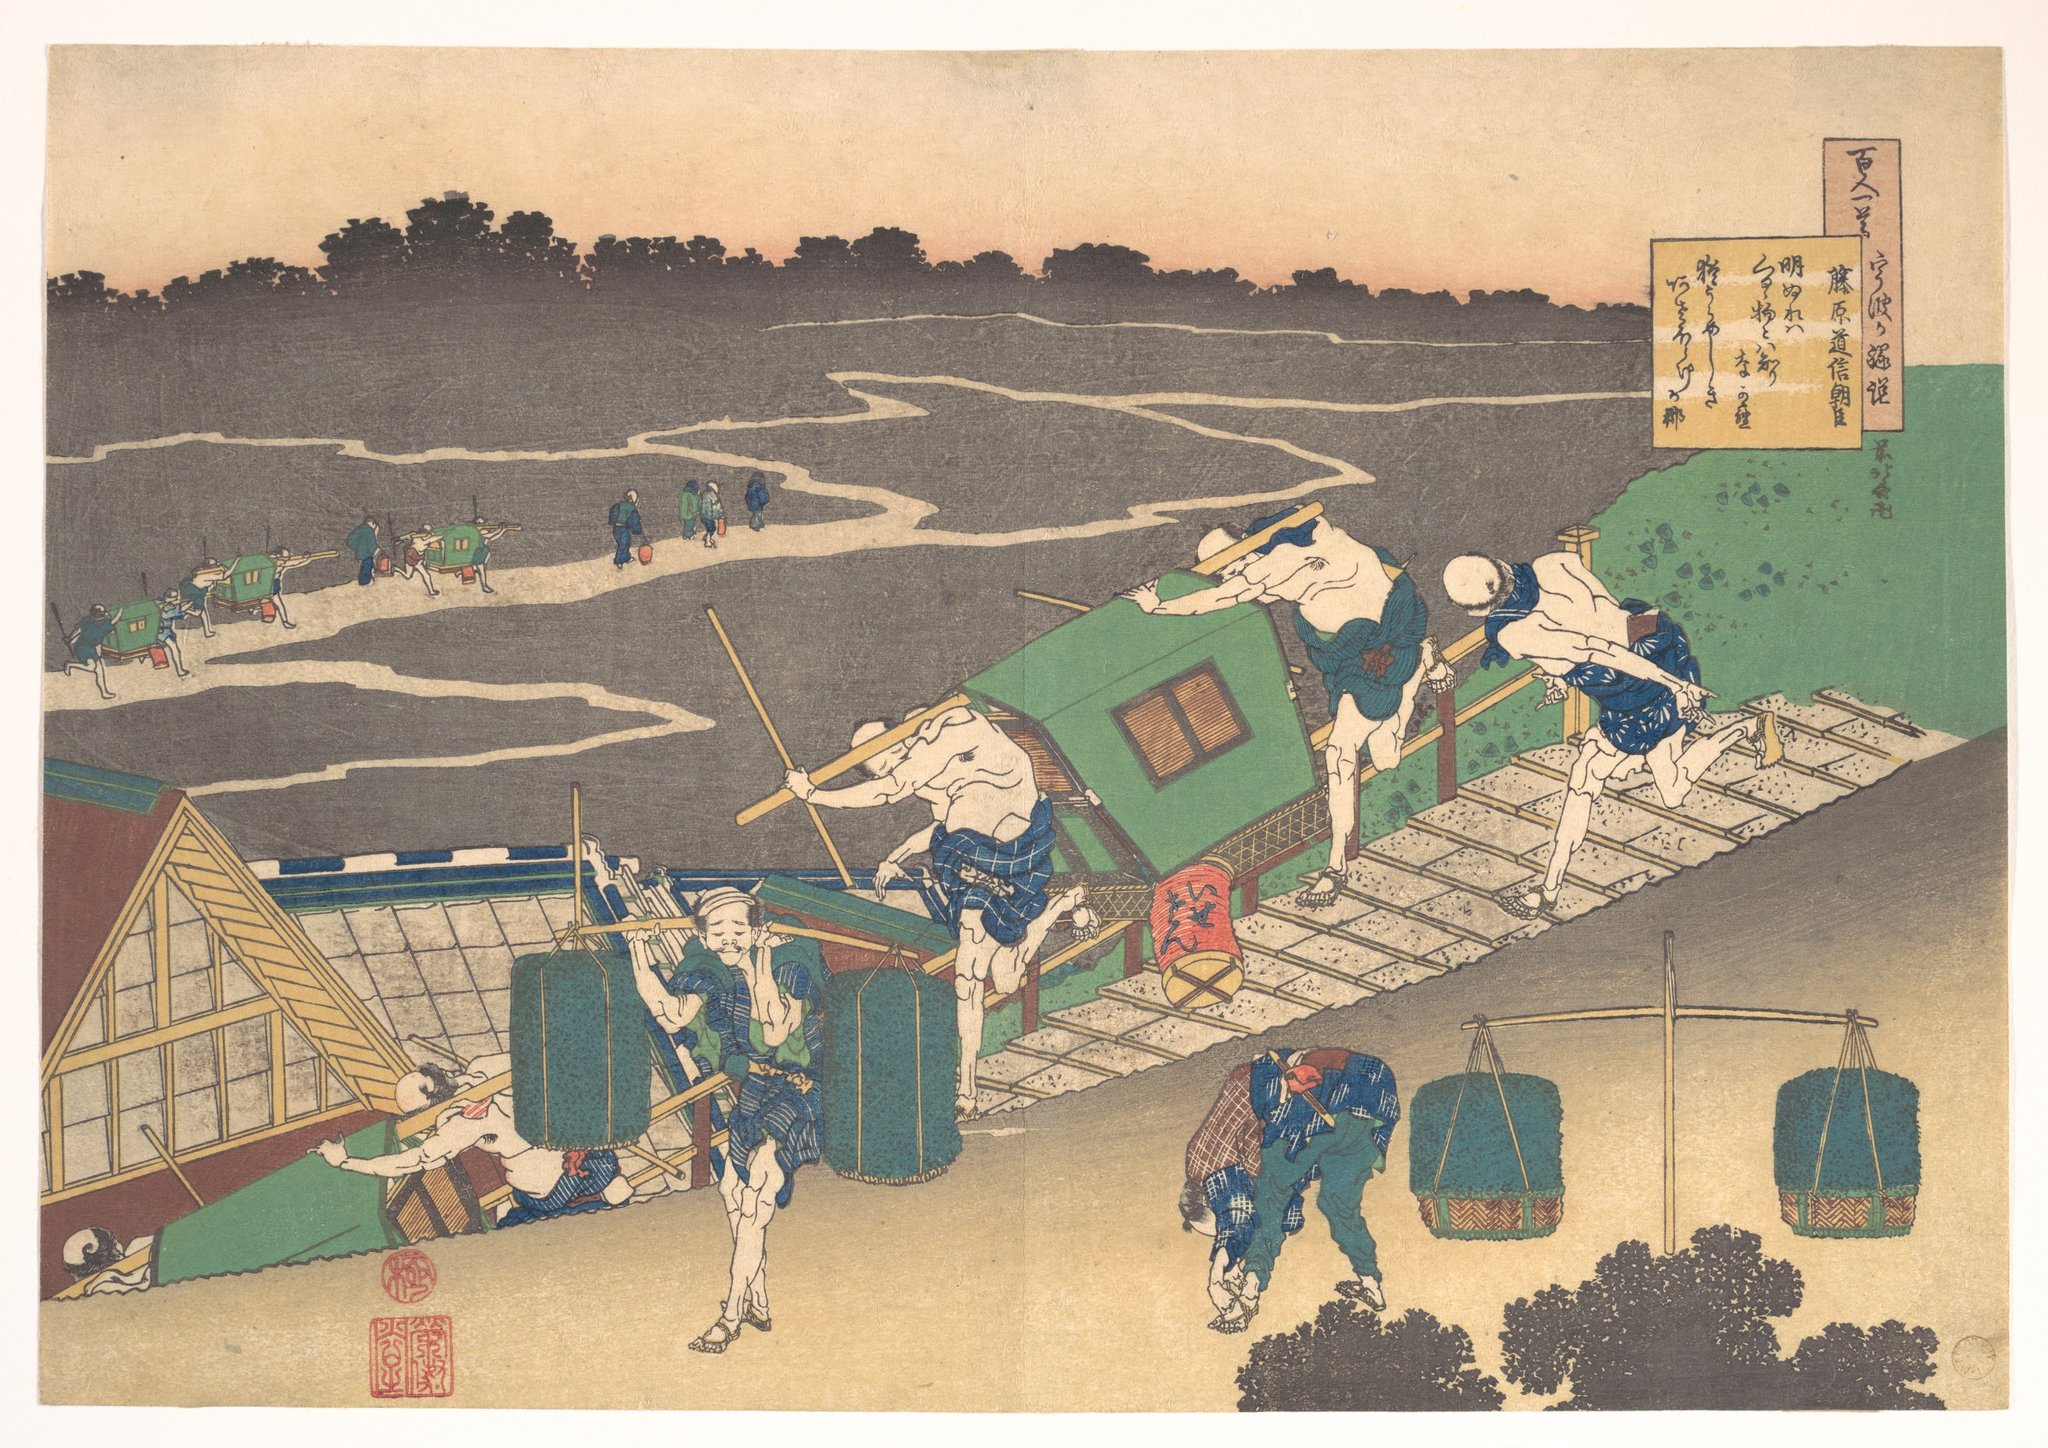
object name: woodblock print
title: Poem by Fujiwara no Michinobu Ason, from the series One Hundred Poems Explained by the Nurse (Hyakunin isshu uba ga etoki)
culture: japanese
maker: katsushika hokusai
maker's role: artist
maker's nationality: japanese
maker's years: 1760-1849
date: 1839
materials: ink, paper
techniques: woodblock print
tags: human figures,men,landscapes,working